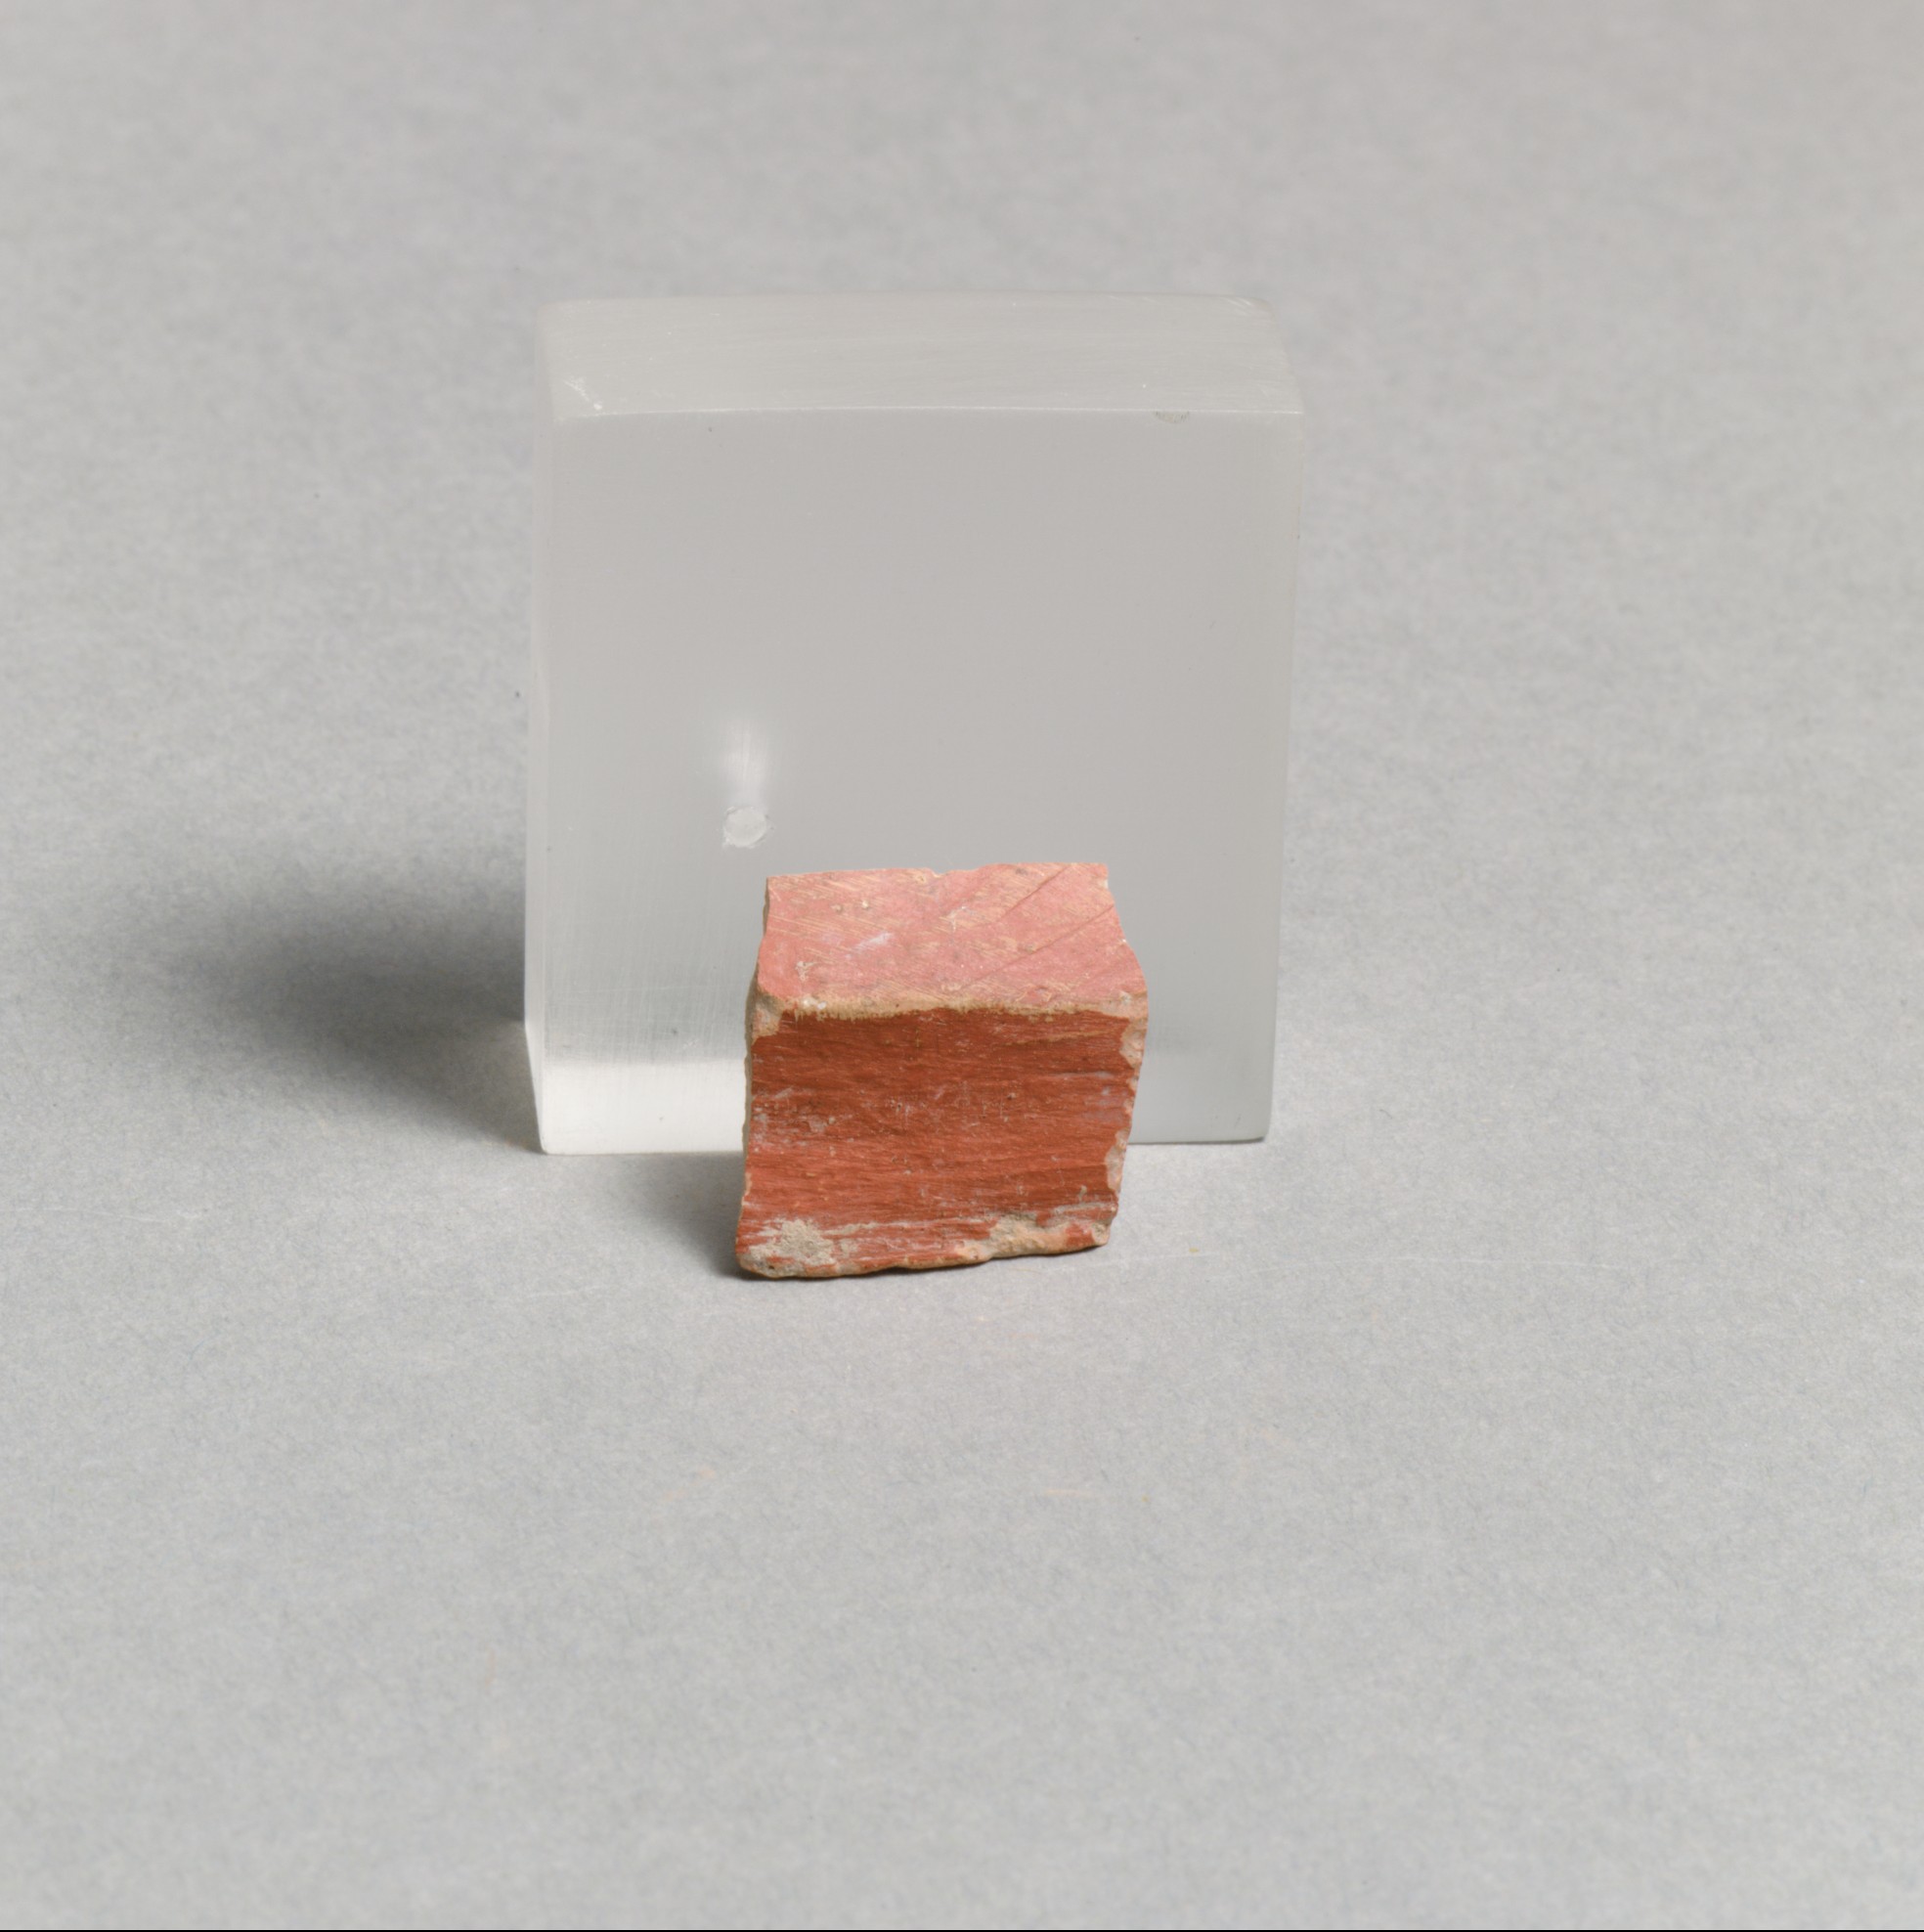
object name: vase fragment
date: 3000-2200 BCE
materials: terracotta